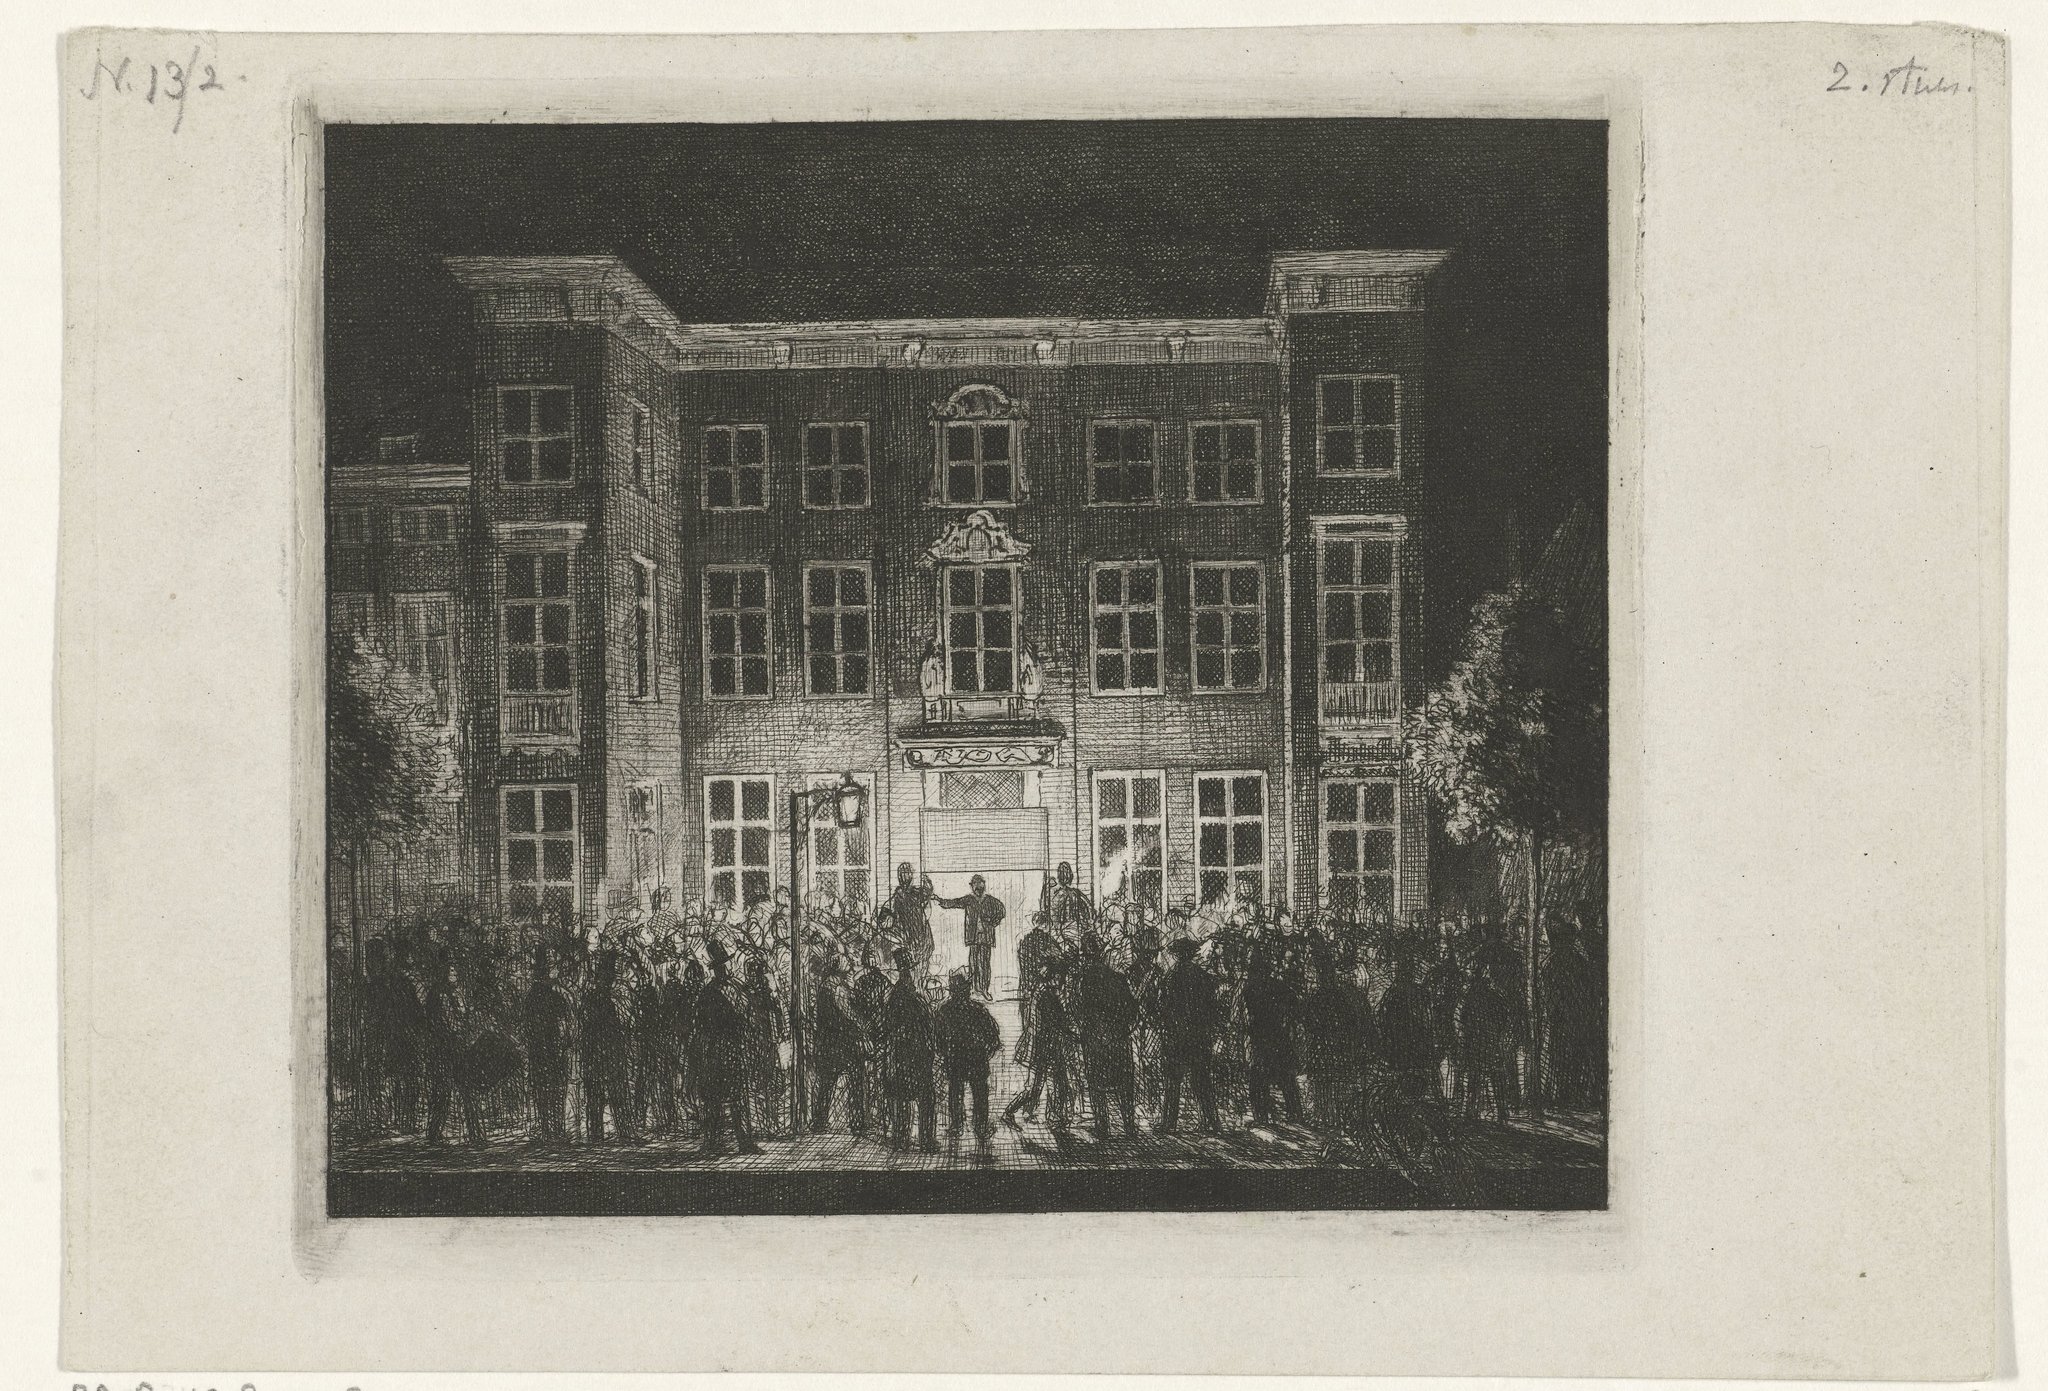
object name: print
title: Begrafenis van de Delftsche academie, 30 juni 1864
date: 1864-1866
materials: paper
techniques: drypoint, etching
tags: funerary ceremonial, delft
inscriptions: collector's mark: Lugt 2228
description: De begrafenis van de Delftsche academie, 30 juni 1864. Nachtelijk tafereel waarbij in de verlichte deuropening van een pand een persoon staat te oreren voor publiek.